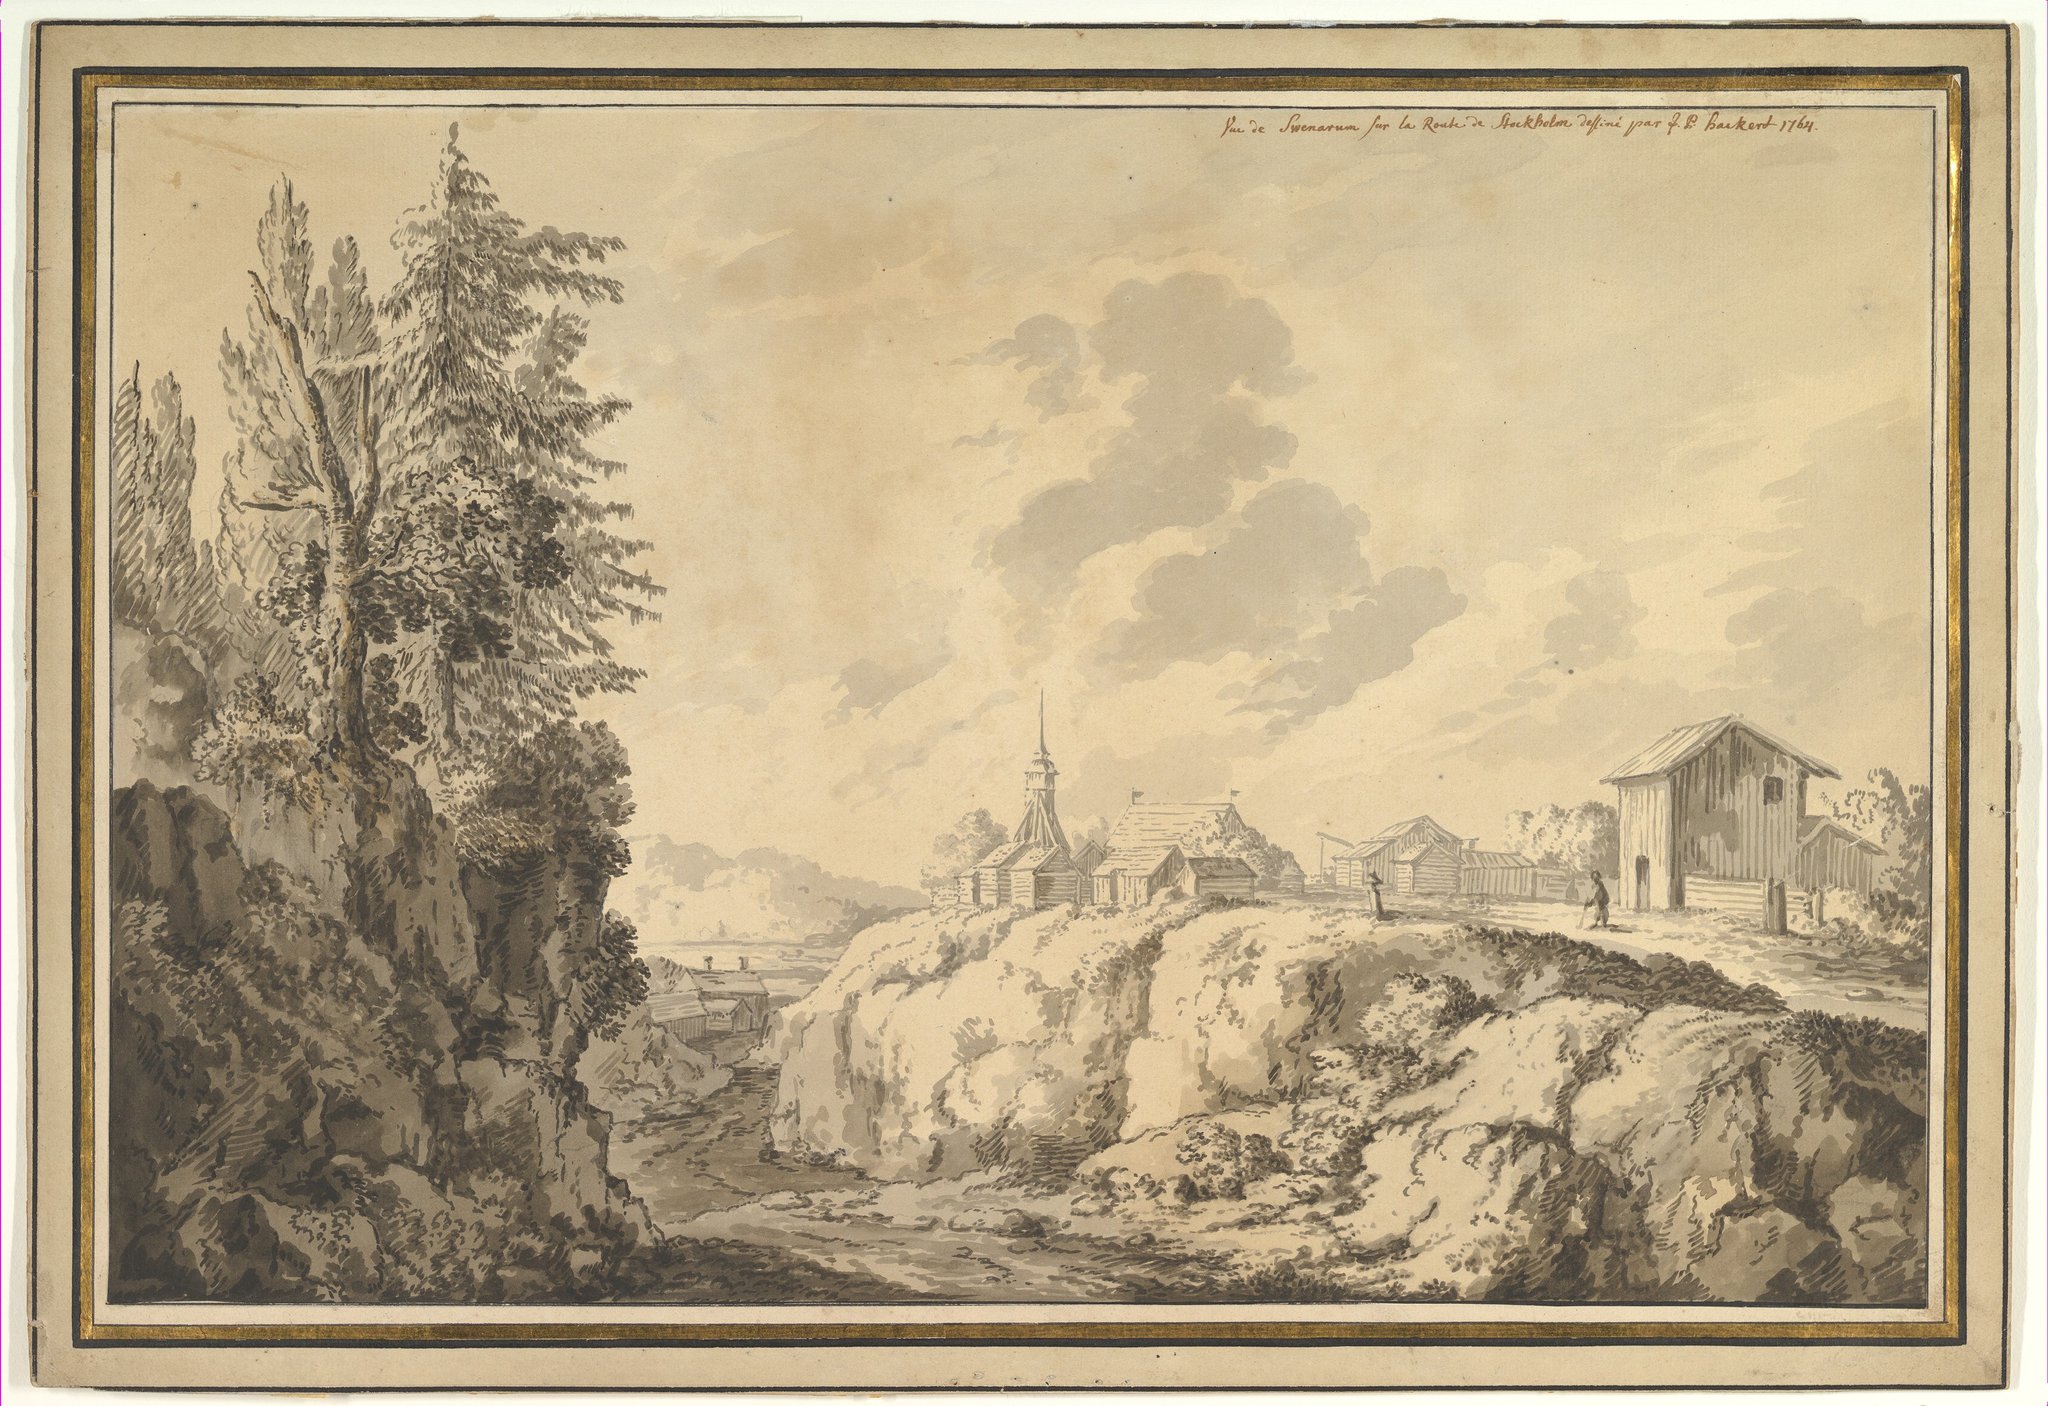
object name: drawing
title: View of Svenarum in the Province of Småland, Sweden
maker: jacob philipp hackert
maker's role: artist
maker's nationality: german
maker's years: 1737-1807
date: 1764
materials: chalk, ink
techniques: brush, pen, wash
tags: landscapes